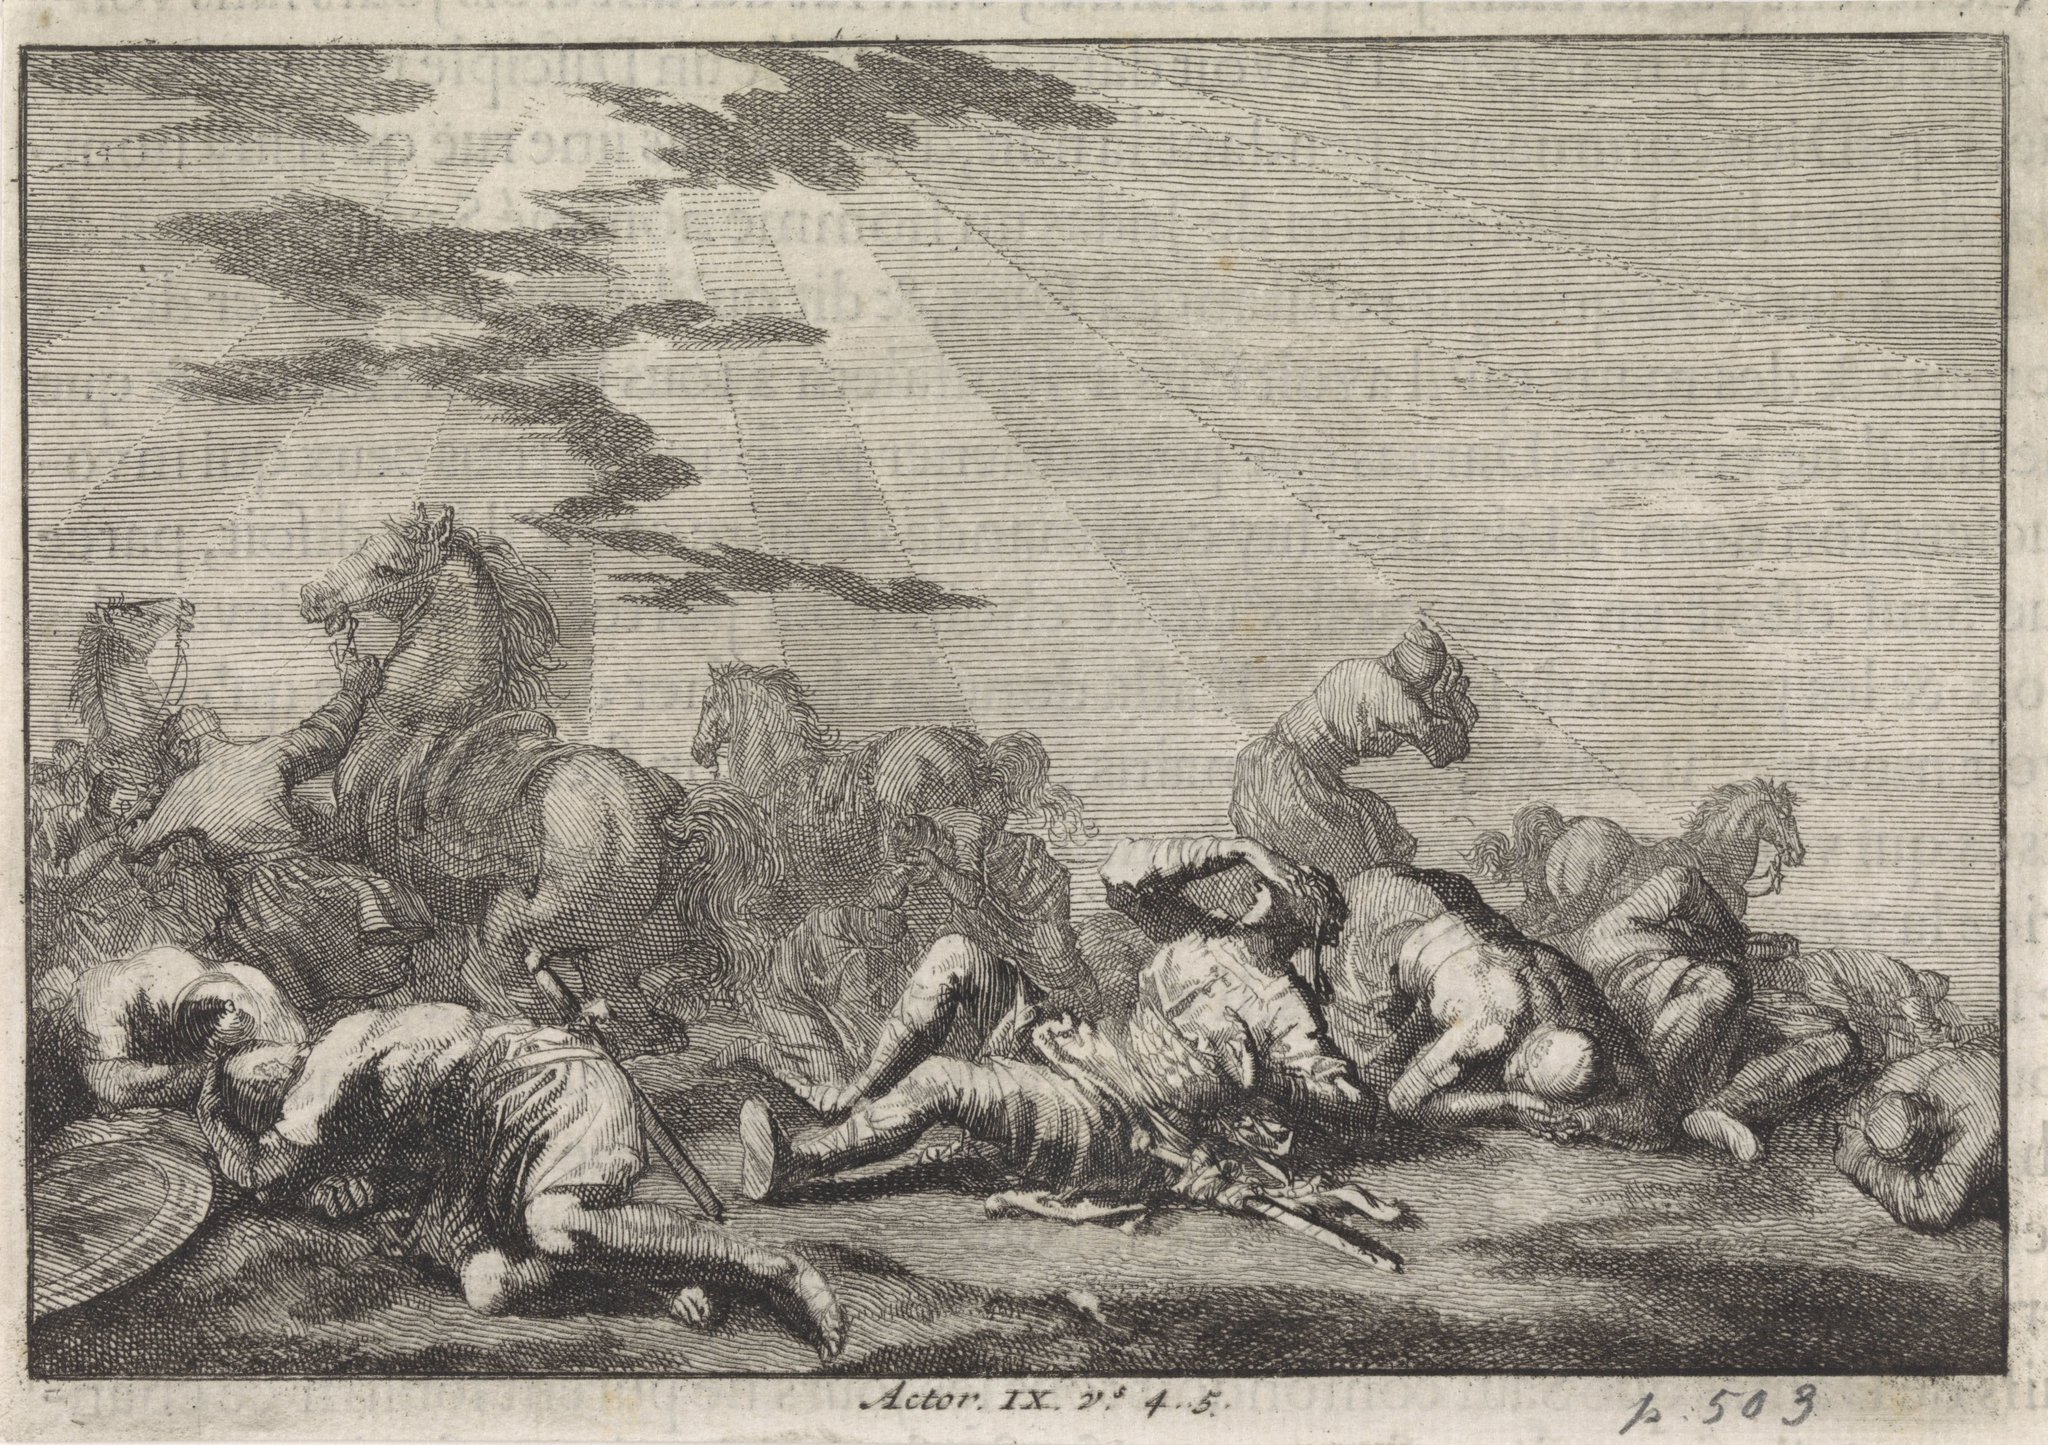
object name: book illustration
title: Bekering van Paulus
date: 1703-1762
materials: paper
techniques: etching, letterpress printing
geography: amsterdam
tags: on the way to damascus christ appears to saul, who falls from his horse and is blinded by the light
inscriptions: collector's mark: Lugt 2228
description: De prent komt een eerste keer voor als boekillustratie voor David Martin. Historie des Ouden en Nieuwen Testaments. Amsterdam, Pieter Mortier, 1703. Deel II. De boekillustraties voor de Mortierbijbel hebben verschillende staten en kopieën, waarbij de chronologische volgorde moeilijk te achterhalen valt. Als boekillustraties werden ze bovendien herhaaldelijk opnieuw gebruikt voor andere boekwerken.